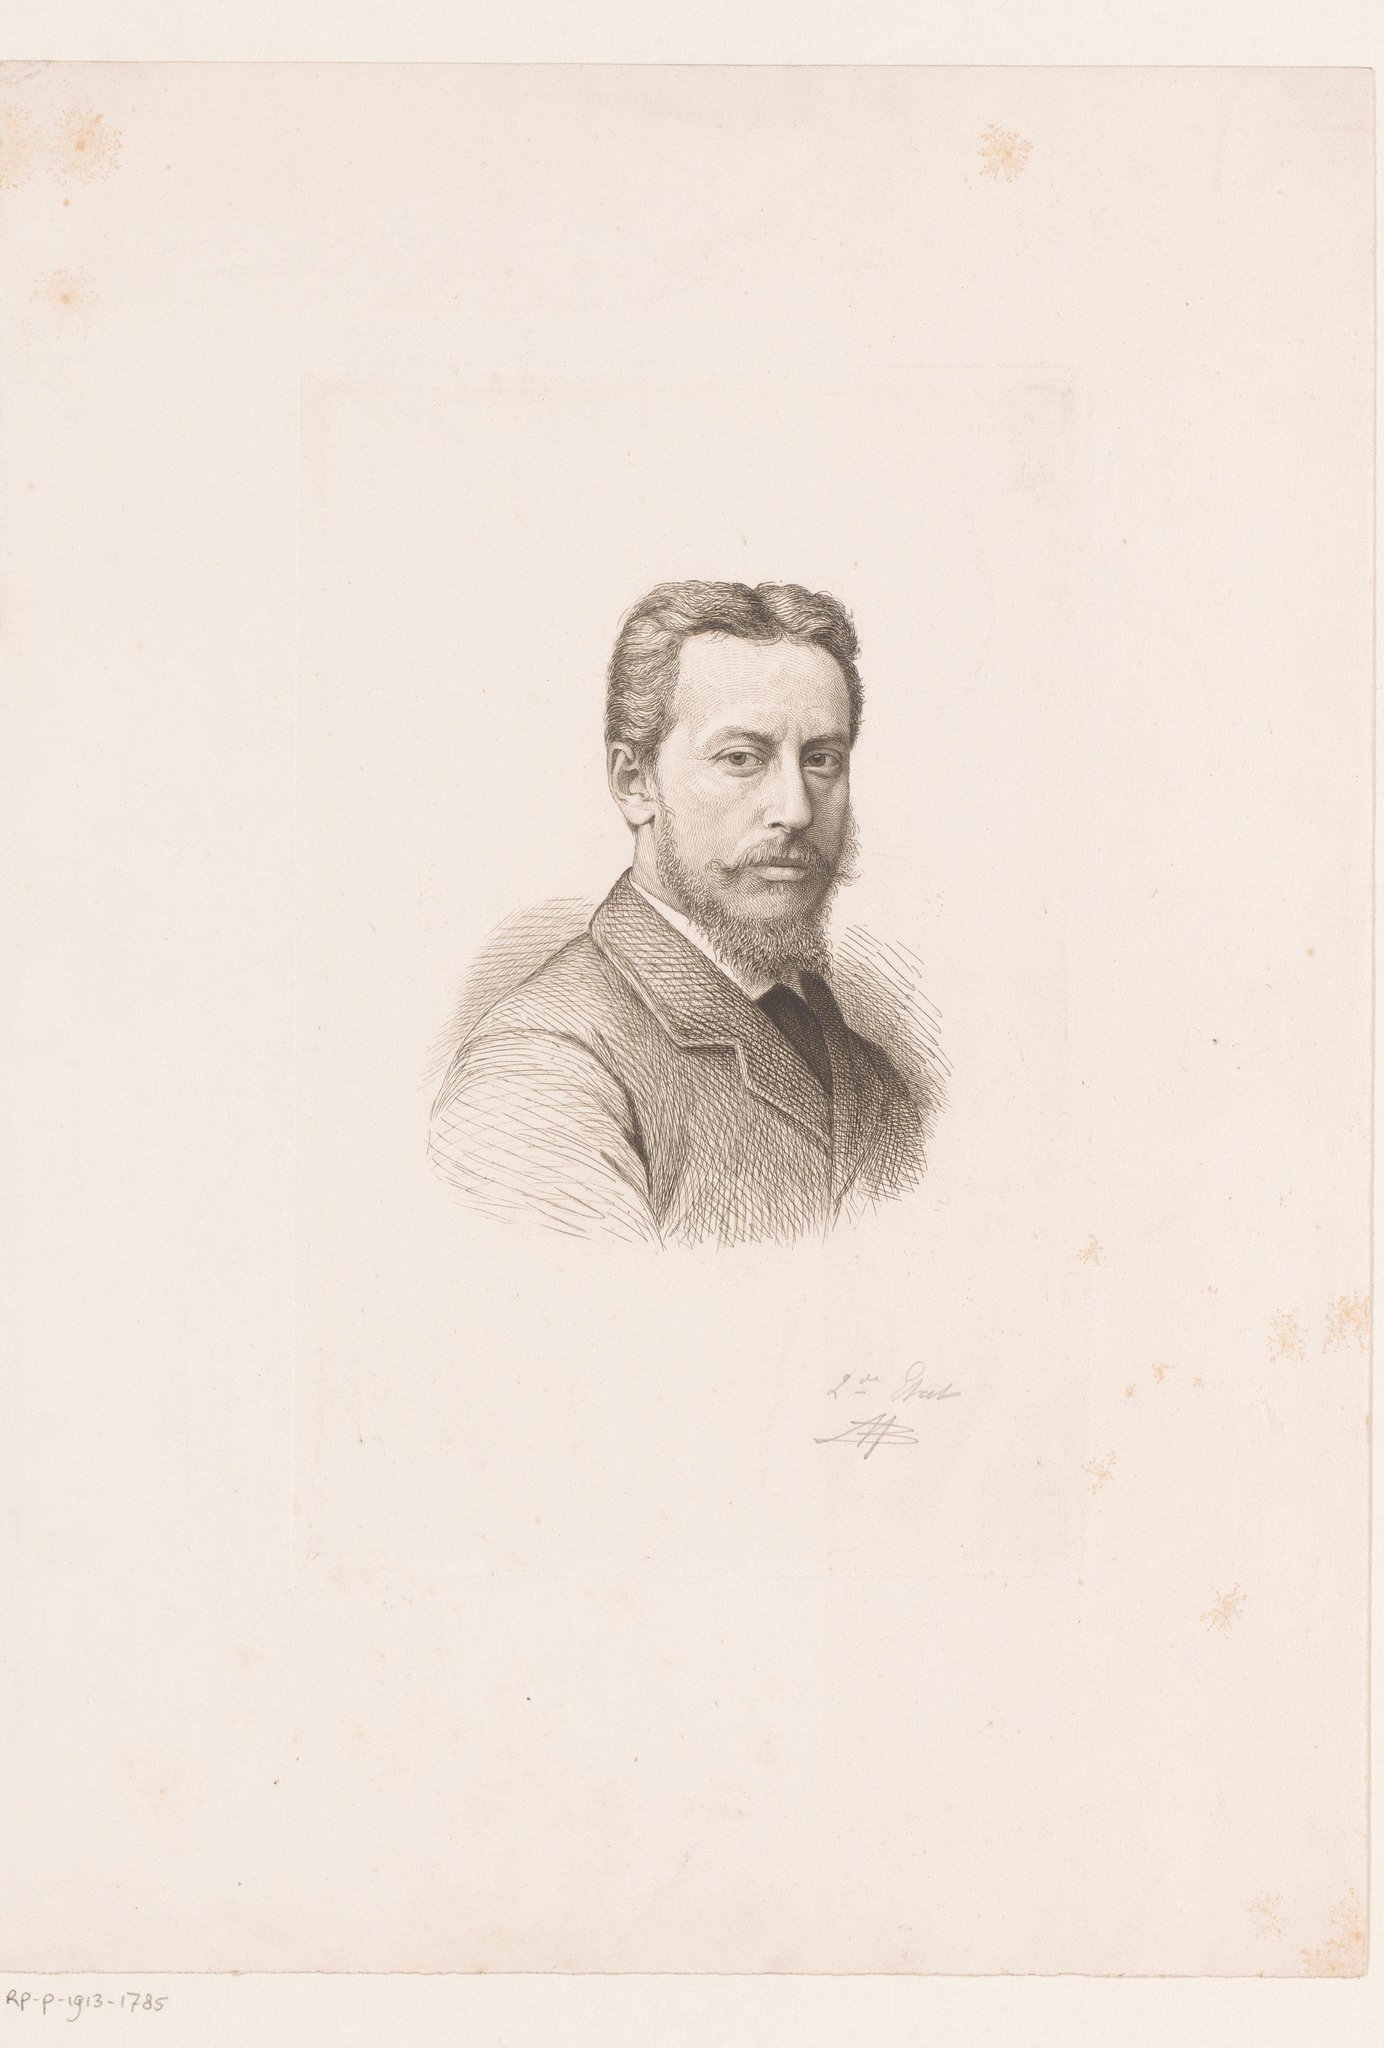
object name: print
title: Portret van Alfred Elsen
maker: jean baptiste pierre michiels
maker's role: print maker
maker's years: 1821-1890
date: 1880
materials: paper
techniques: etching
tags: antwerp, painter, alfred elsen, adult man, historical persons, beard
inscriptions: collector's mark: Lugt 2228